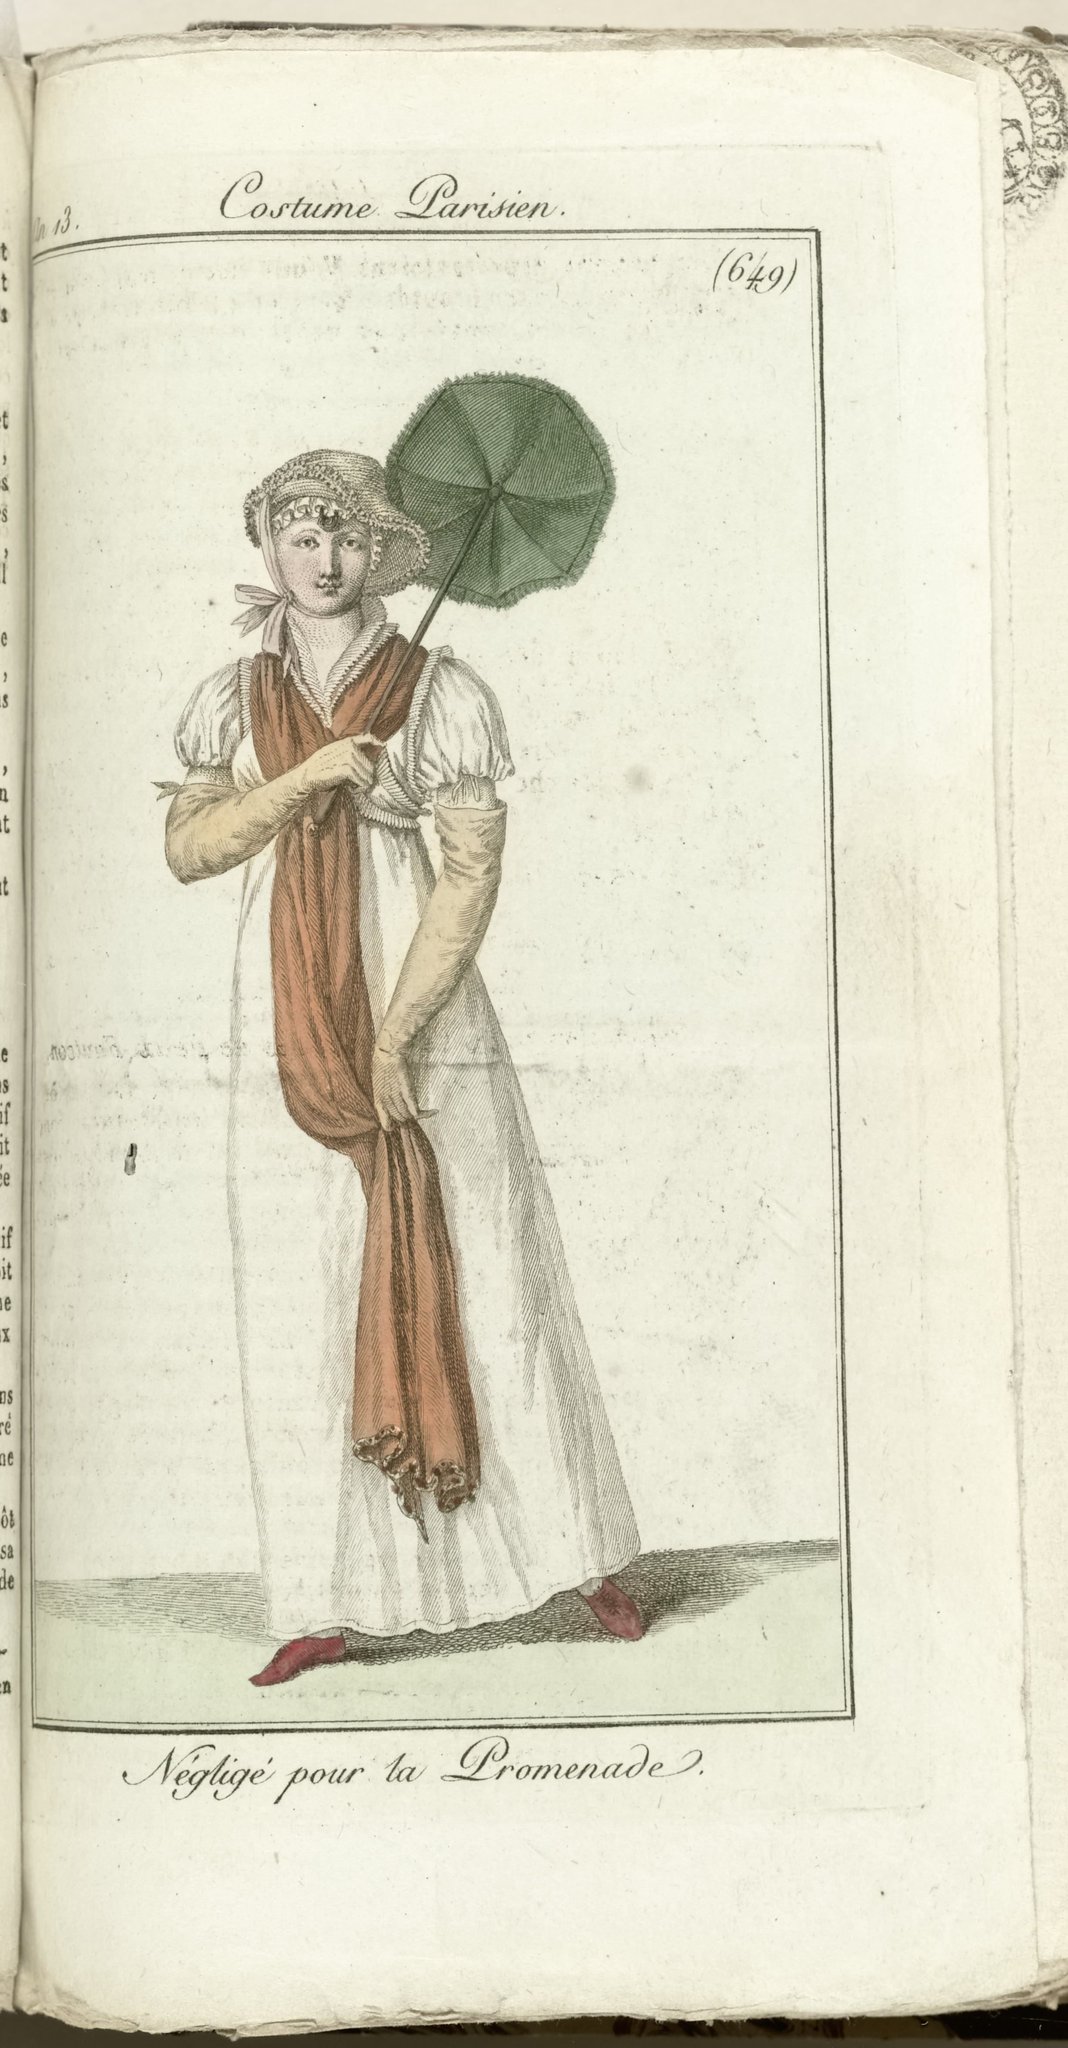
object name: fashion print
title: Journal des Dames et des Modes, Costume Parisien, 1805, An 13 (649) Négligé pour la Promenade.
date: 1805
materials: paper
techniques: engraving, hand coloring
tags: gloves, mittens (long gloves) (+ women's clothes), dress, gown: walking dress (+ women's clothes), neck-gear ~ clothing (shawl) (+ women's clothes), head-gear (straw hat) (+ women's clothes), head-gear (bonnet) (+ women's clothes), fashion plates, parasol, sunshade (+ women's clothes)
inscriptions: title: ‘Négligé pour la Promenade.’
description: Vrouw met kleine parasol in de hand, gekleed in een witte japon voor de wandeling, waaroverheen een rode jaal. Lange handschoenen, rode platte schoenen. Op het hoofd een strohoedje over een bonnet.